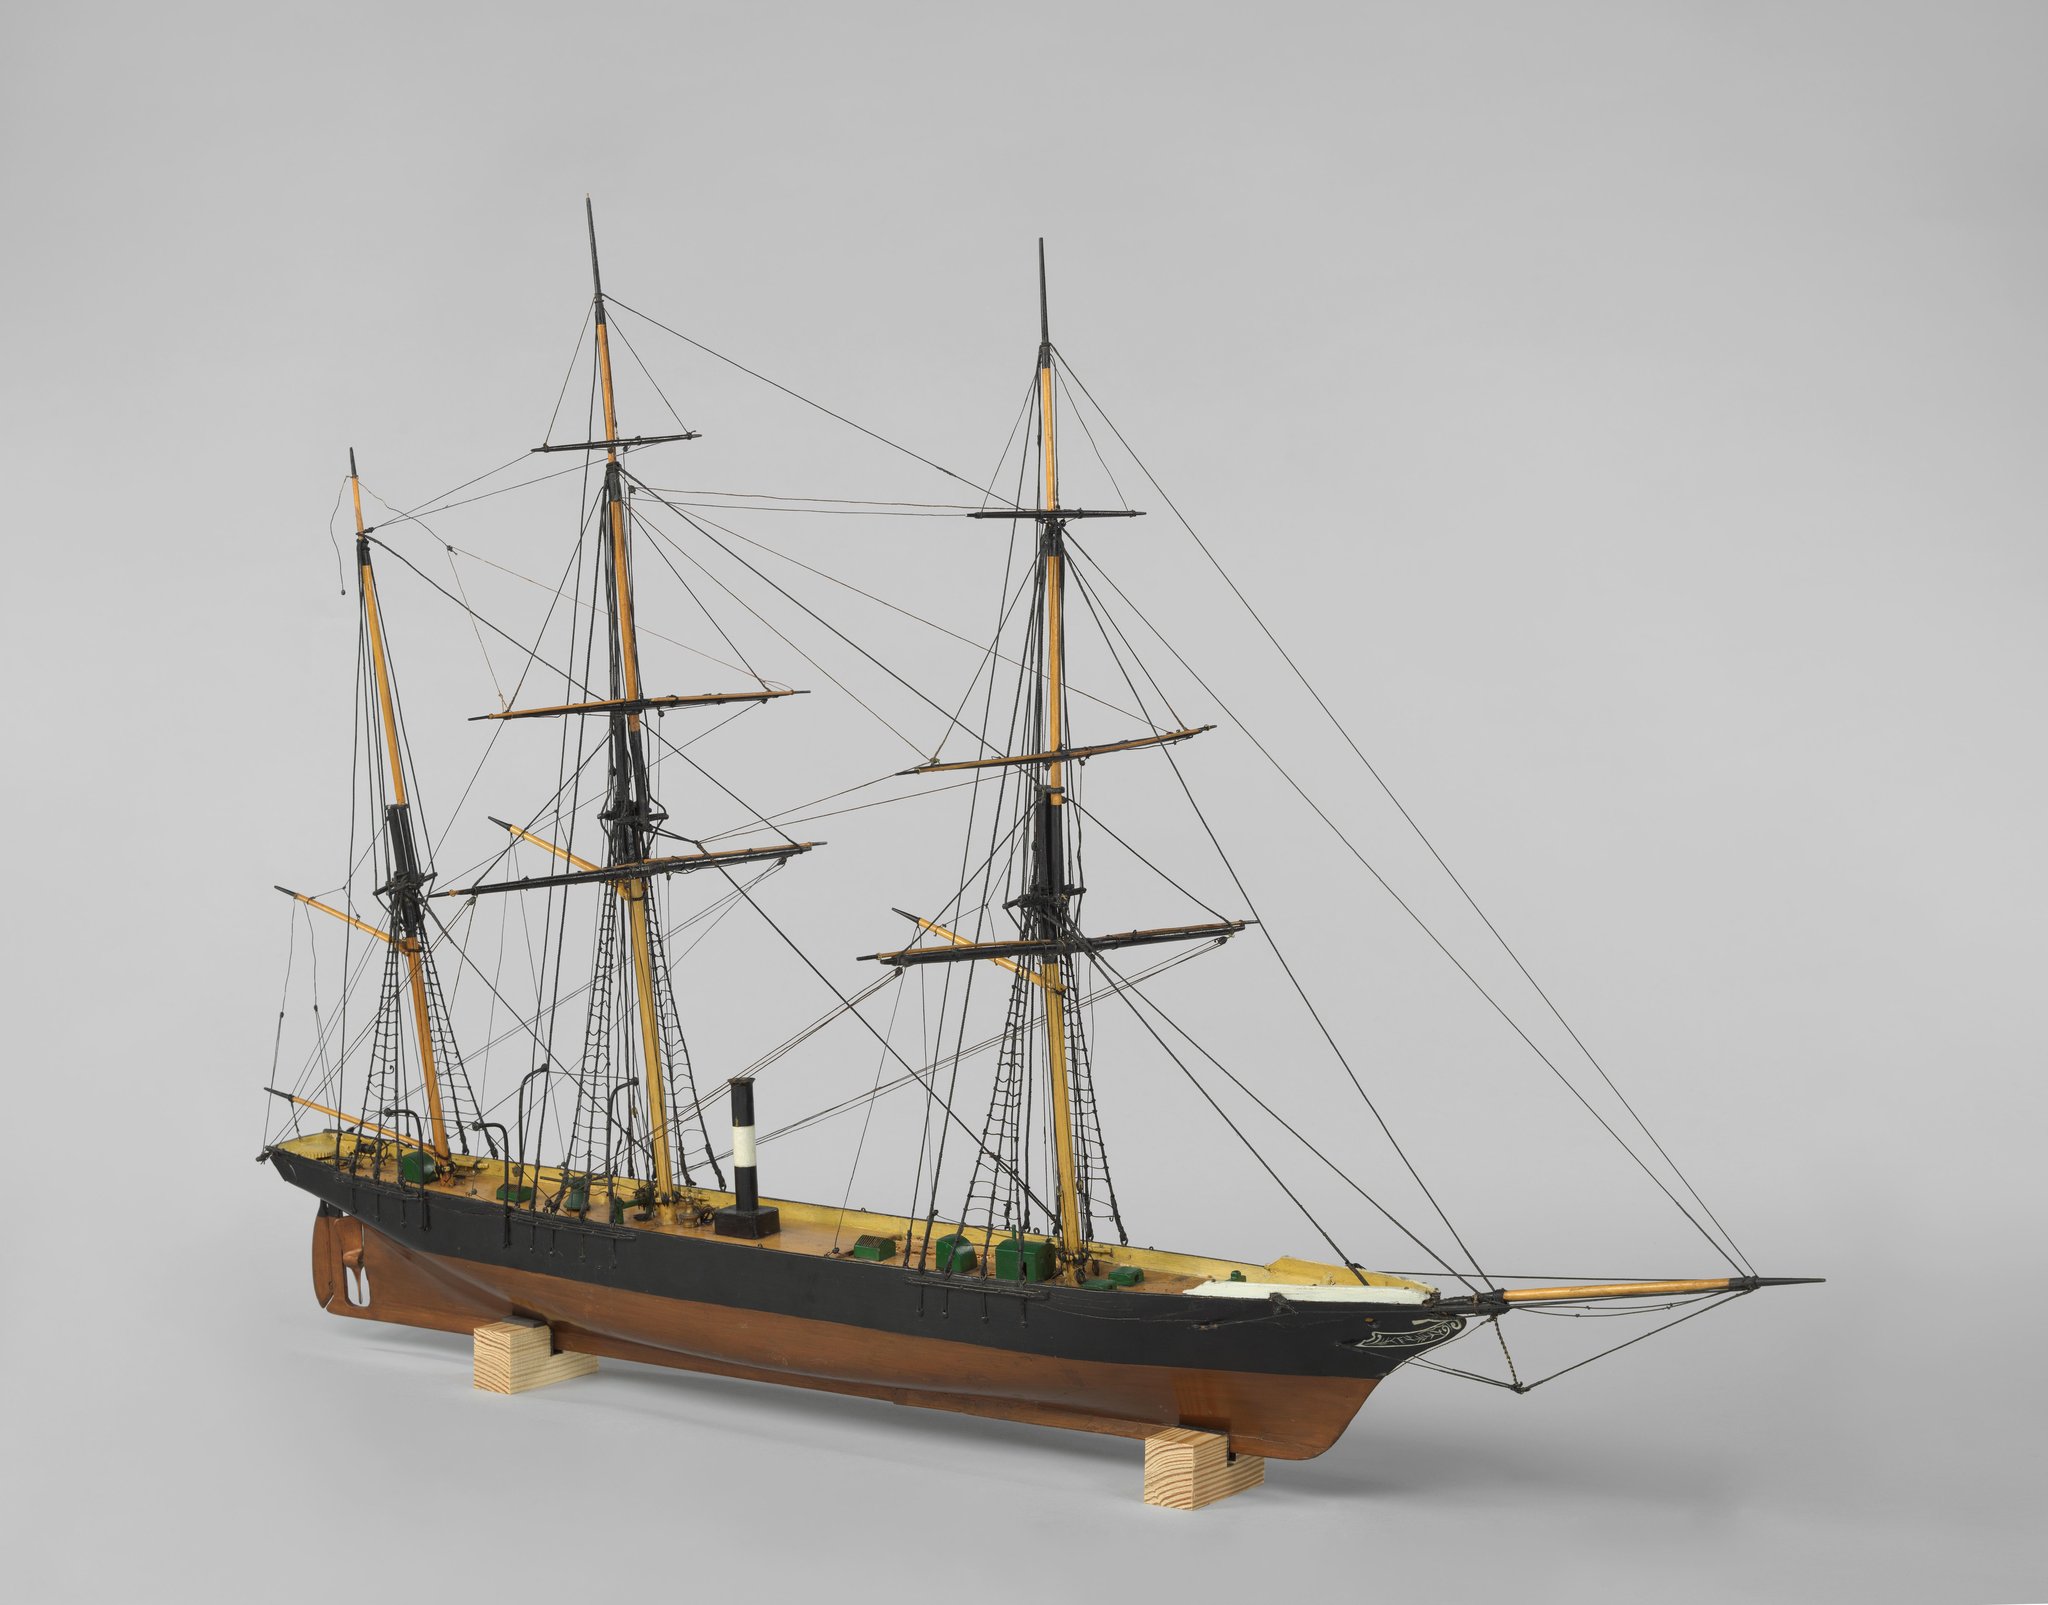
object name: fully rigged model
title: Model of a Screw Steamer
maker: Anonymous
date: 1850-1870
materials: brass, lead, fiber, textile, wood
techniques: polychromy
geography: netherlands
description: Gepolychromeerd en getuigd blokmodel van een driemast schroefstoomschip uit de collectie van de marineschilder Jacob Eduard van Heemskerck van Beest. Het betreft een varend model, met loden kielbalk en van oorsprong functionerende schroefaandrijving door middel van een, thans ontbrekend, stoommachientje. Het model is in 2021-2022 gerestaureerd, waarbij de masten en tuigage hersteld zijn.